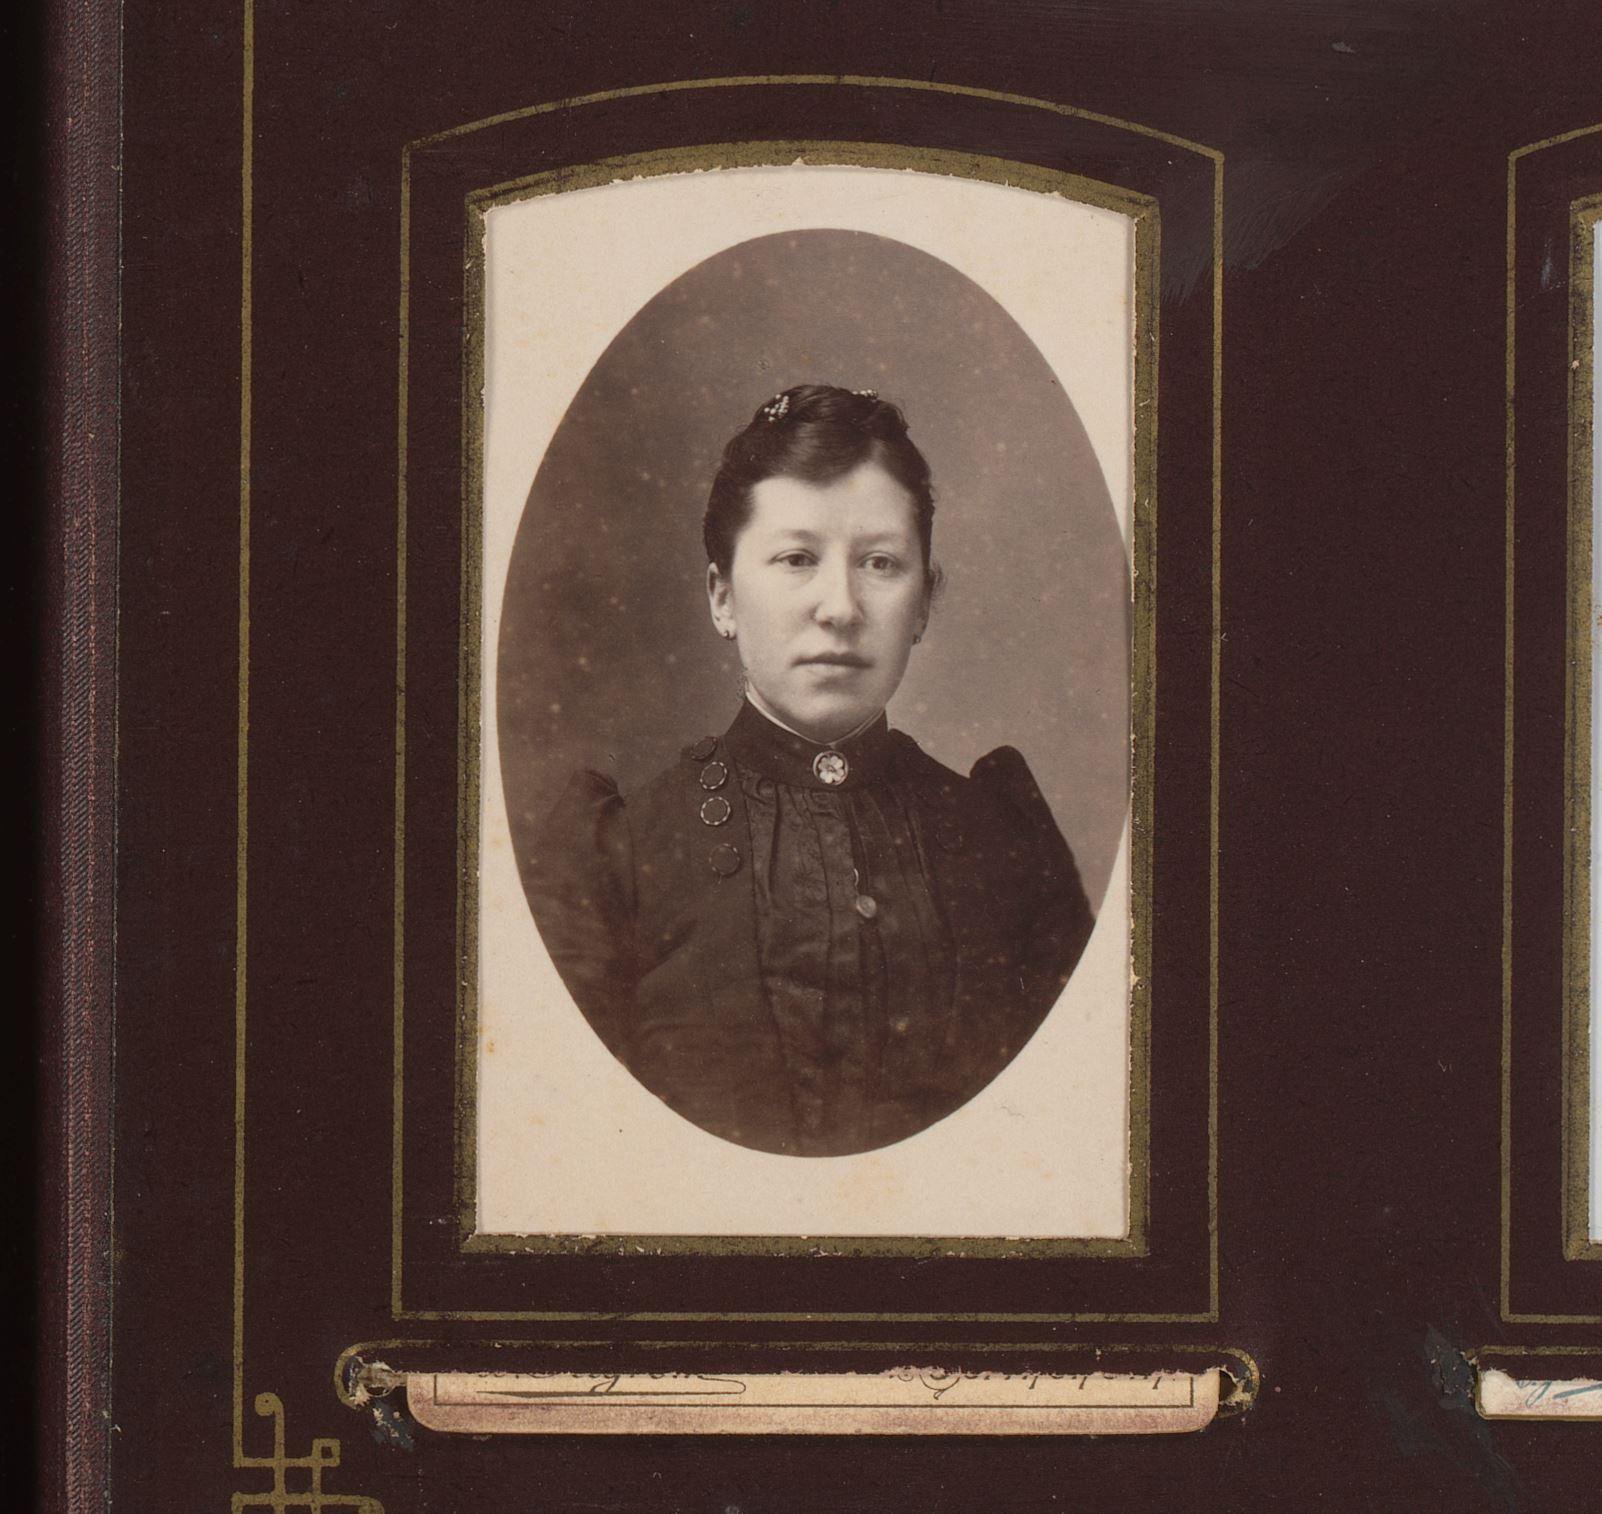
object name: photograph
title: Portret van een vrouw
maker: willem pelgrom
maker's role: fotograaf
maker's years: 1854-1916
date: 1884-1900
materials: cardboard, photographic support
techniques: albumen print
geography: gorinchem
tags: historical persons - bb - woman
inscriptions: inscription: ‘Photographie/ Instantanée/ W. Pelgrom/ Zusterstraat No. 449./ Gorinchem./ De plaat blijft ter nabestelling bewaard./ Specialiteit in Vergrootingen.’